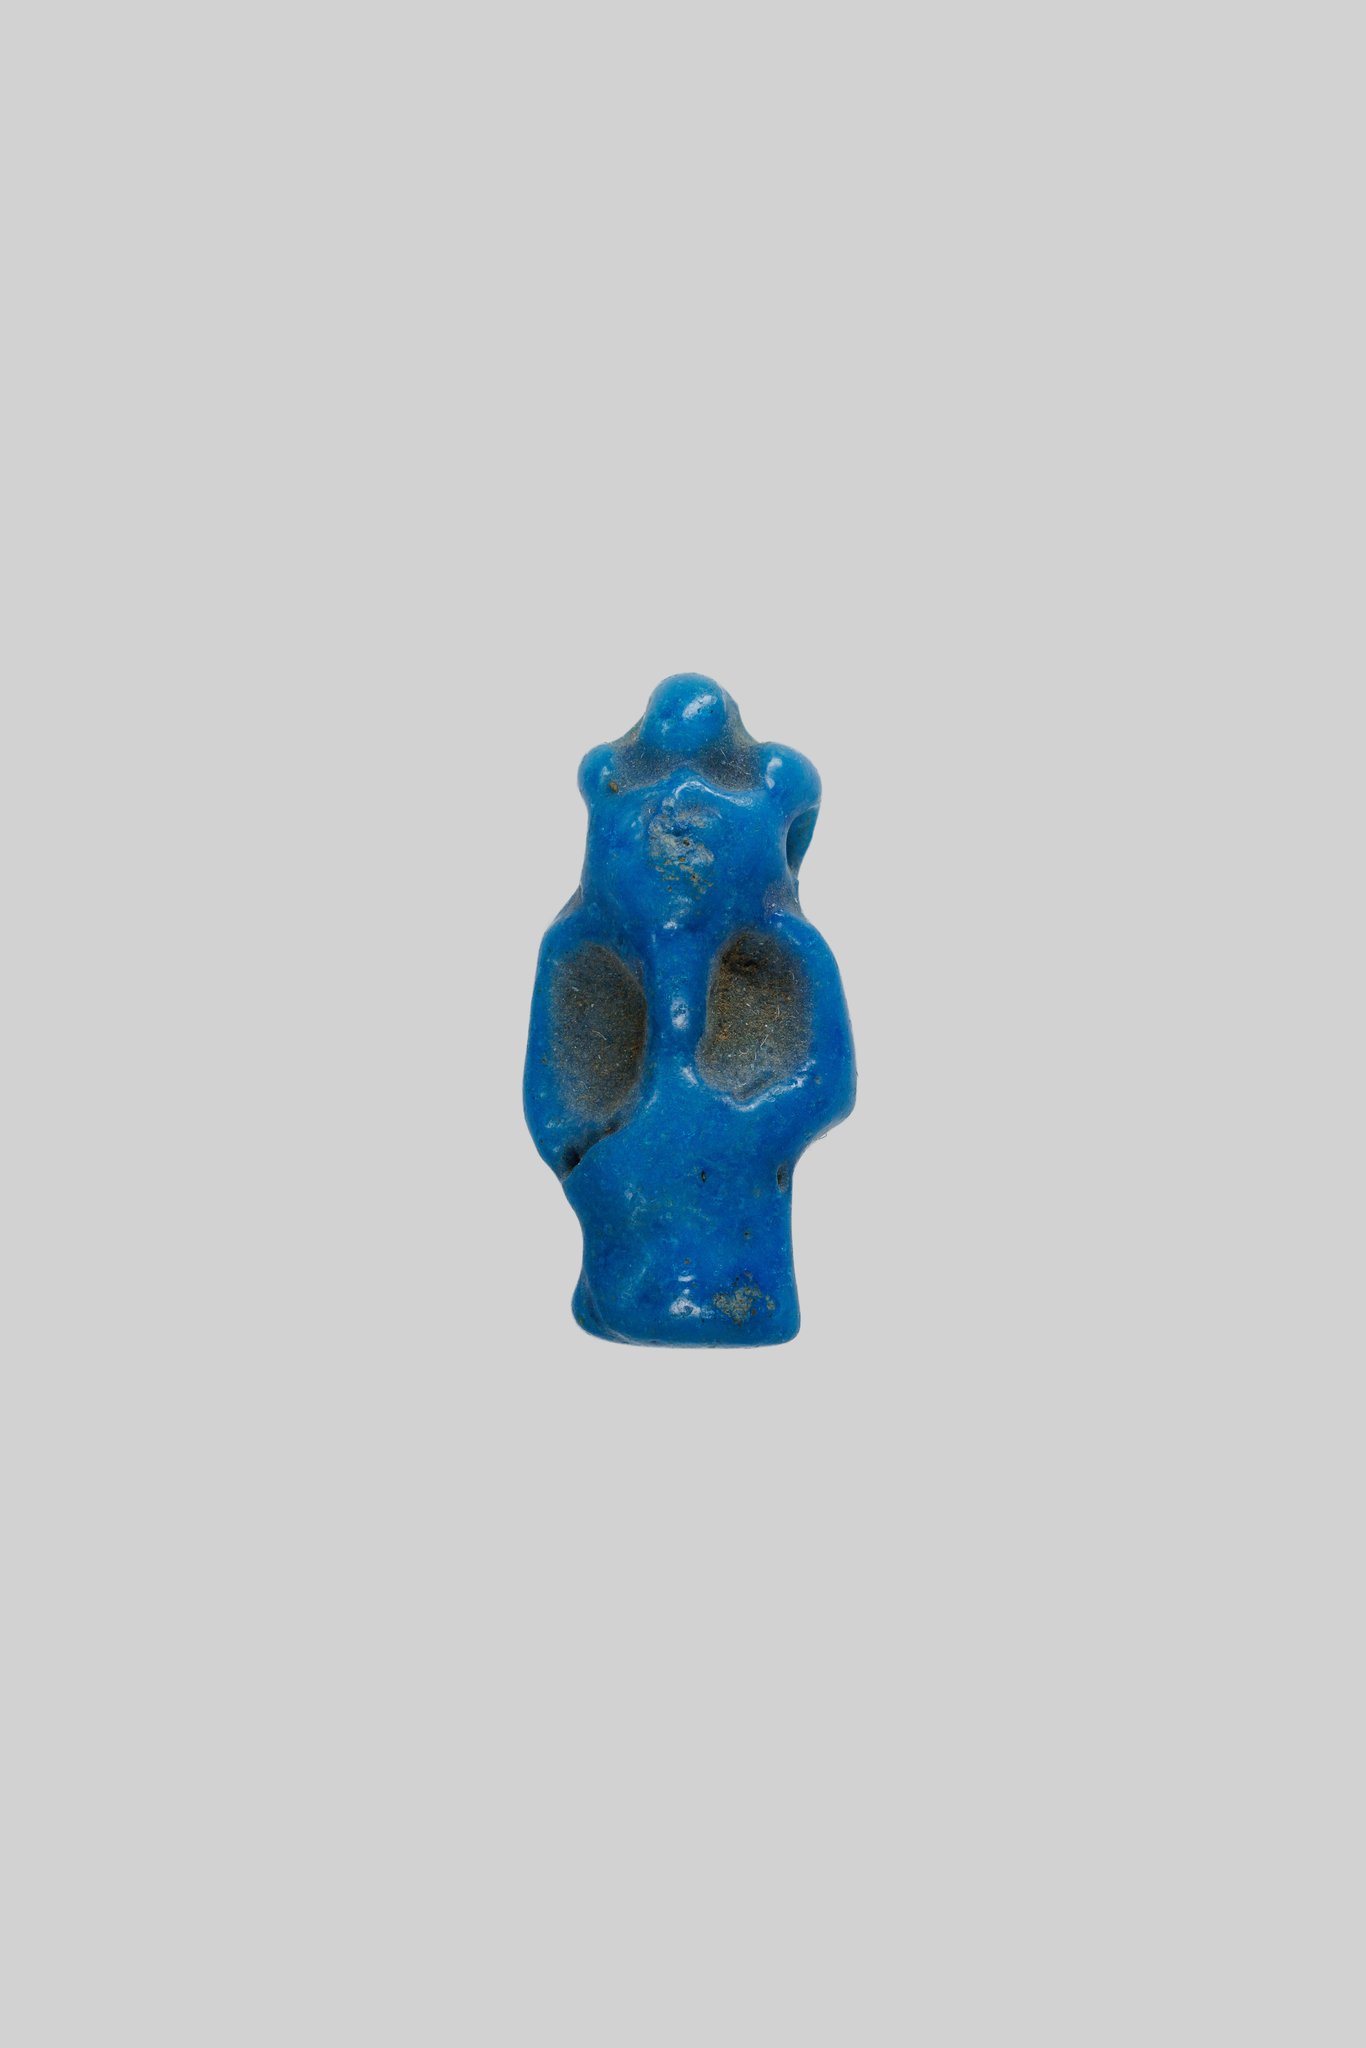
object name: amulet, sakhmet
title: Amulet, possibly of Sakhmet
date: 1295-1070 BCE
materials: faience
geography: egypt